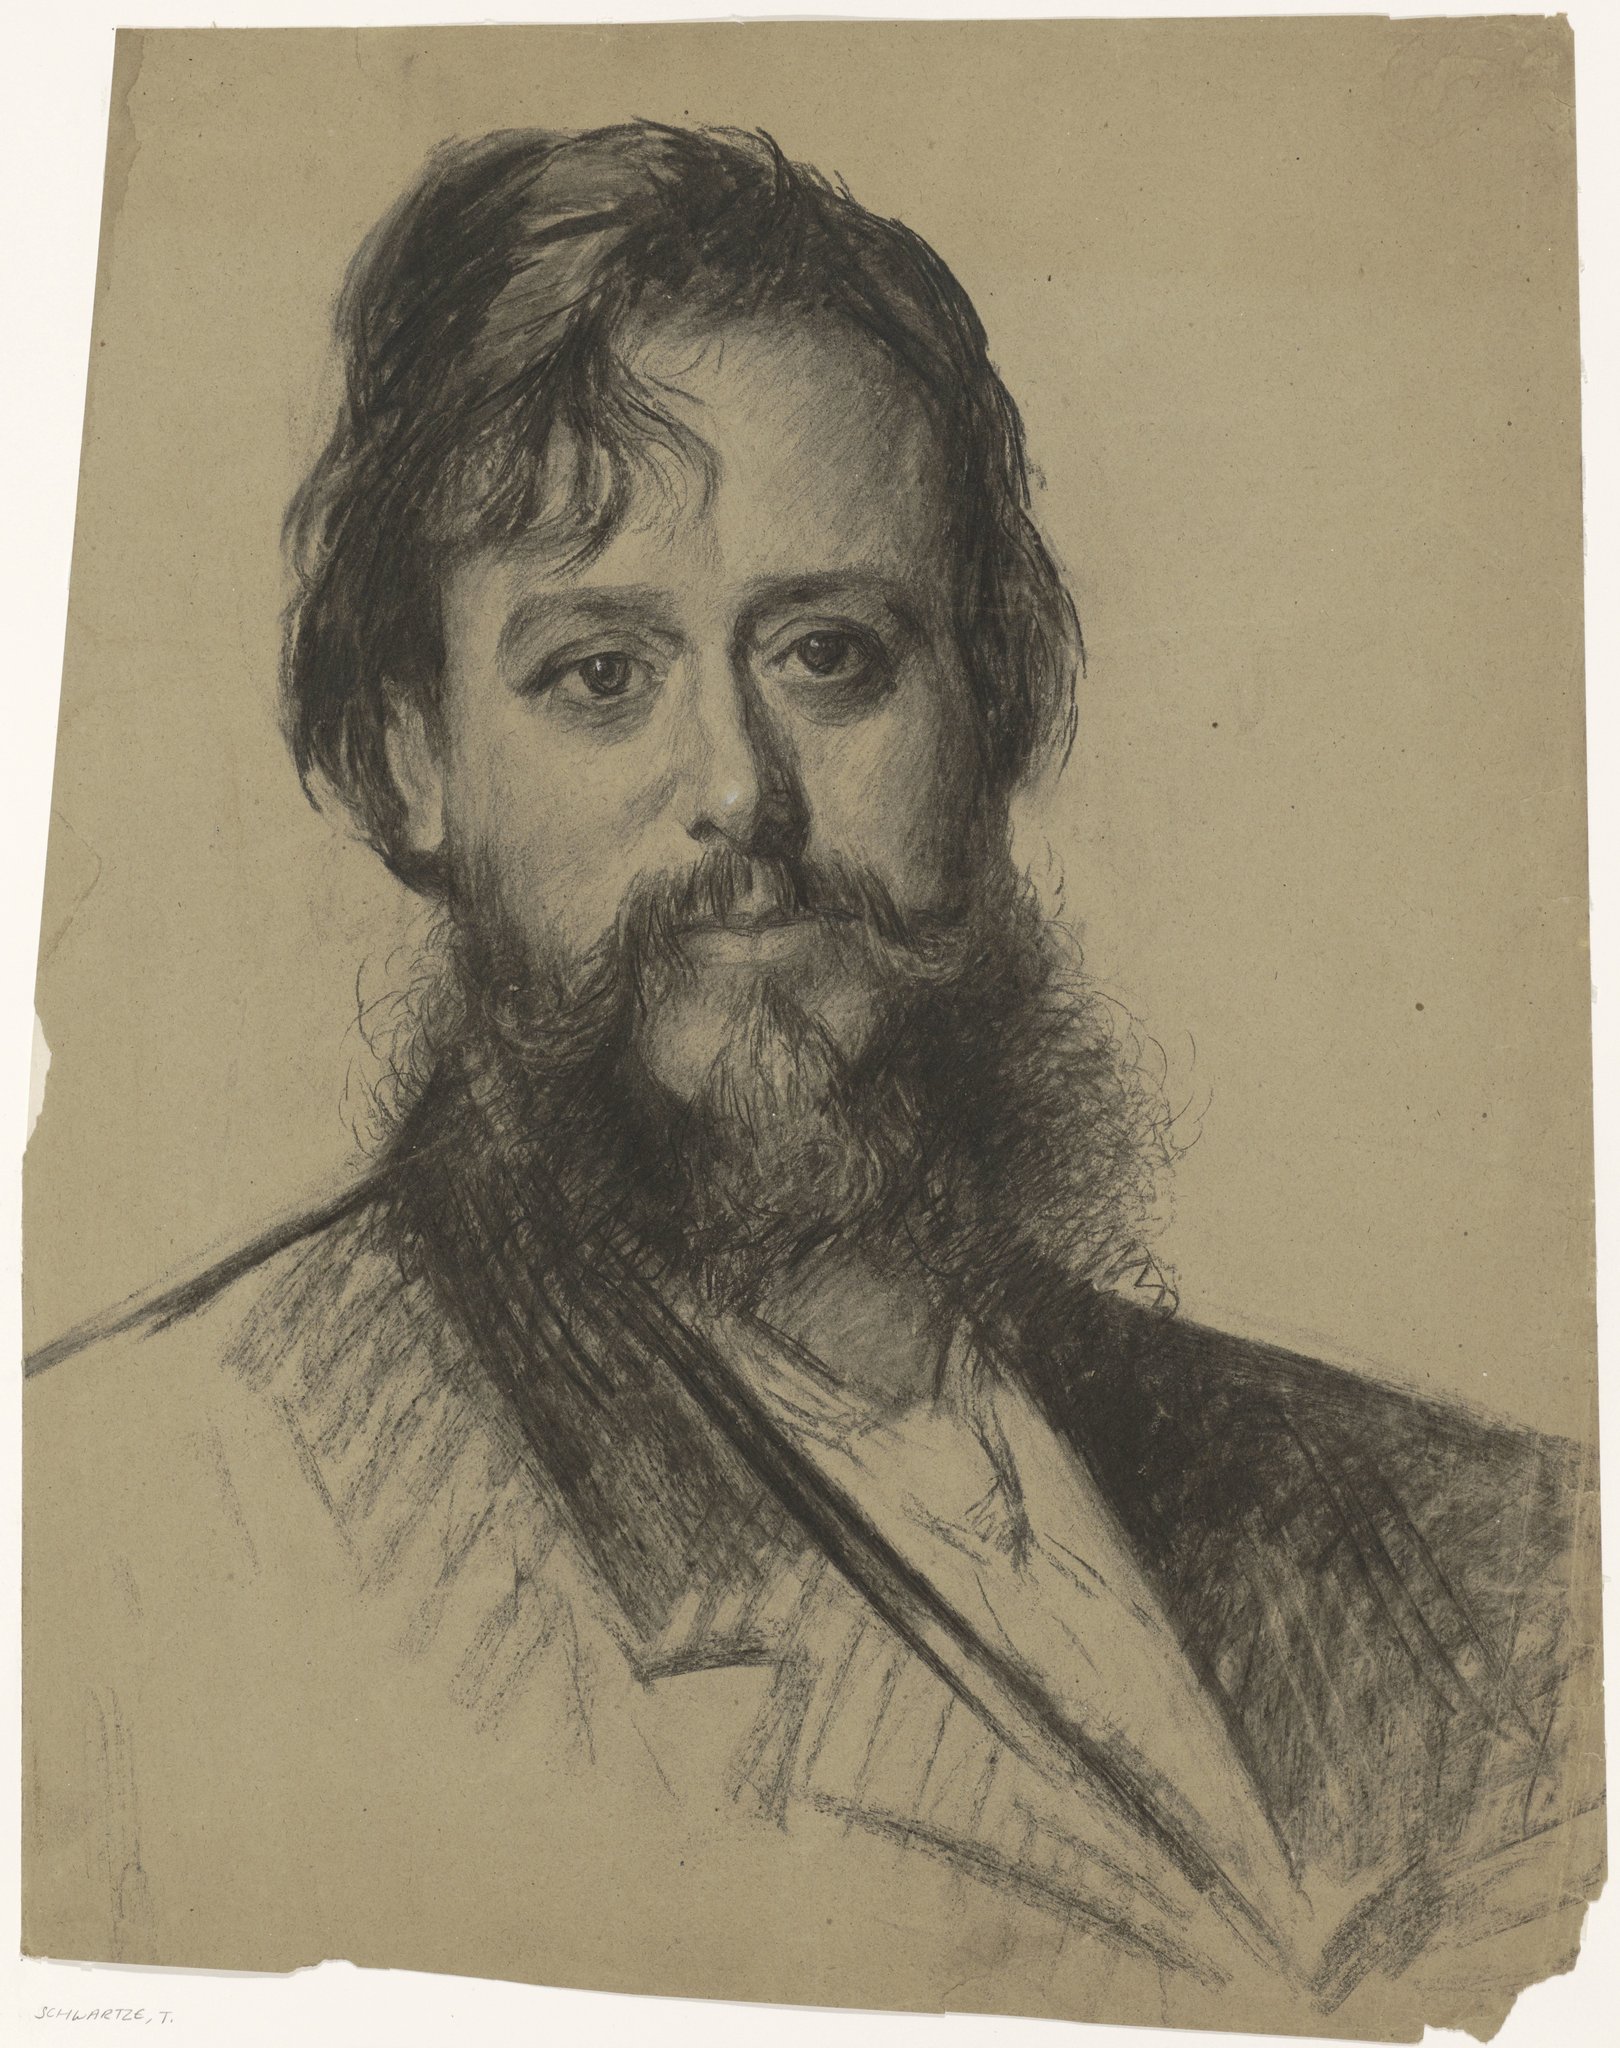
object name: drawing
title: Portret van een man met baard, van voren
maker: thérèse schwartze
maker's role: draughtsman, painter, print maker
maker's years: 1851-1918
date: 1861-1918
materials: chalk, paper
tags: anonymous historical person portrayed alone